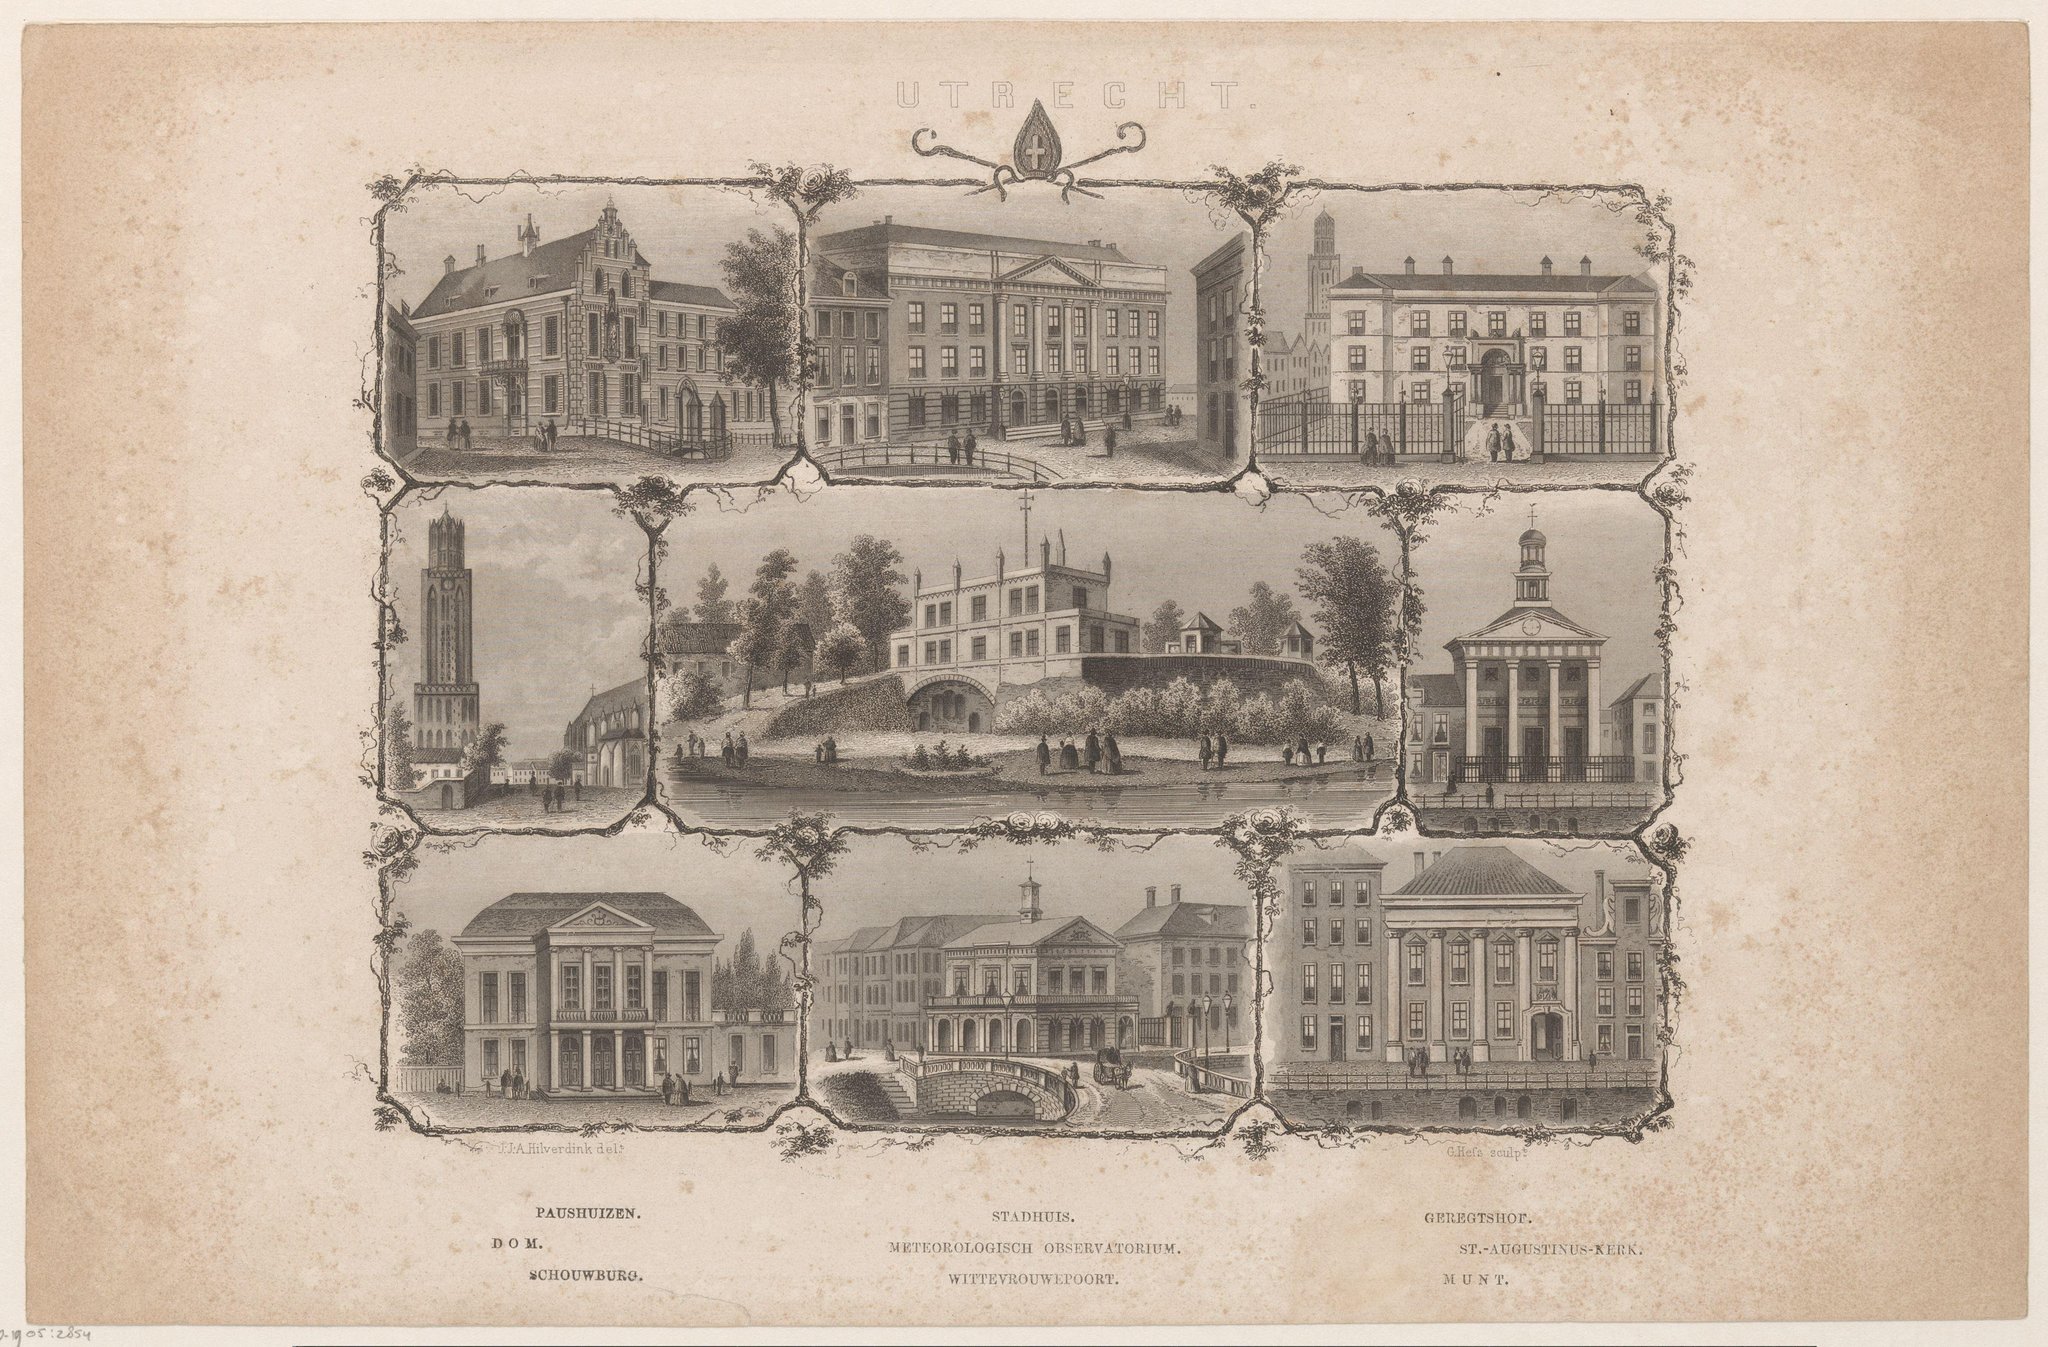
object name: print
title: Negen gebouwen in de gemeente Utrecht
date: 1800-1899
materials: paper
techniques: etching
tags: city-view, and landscape with man-made constructions, utrecht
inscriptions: collector's mark: Lugt 2228